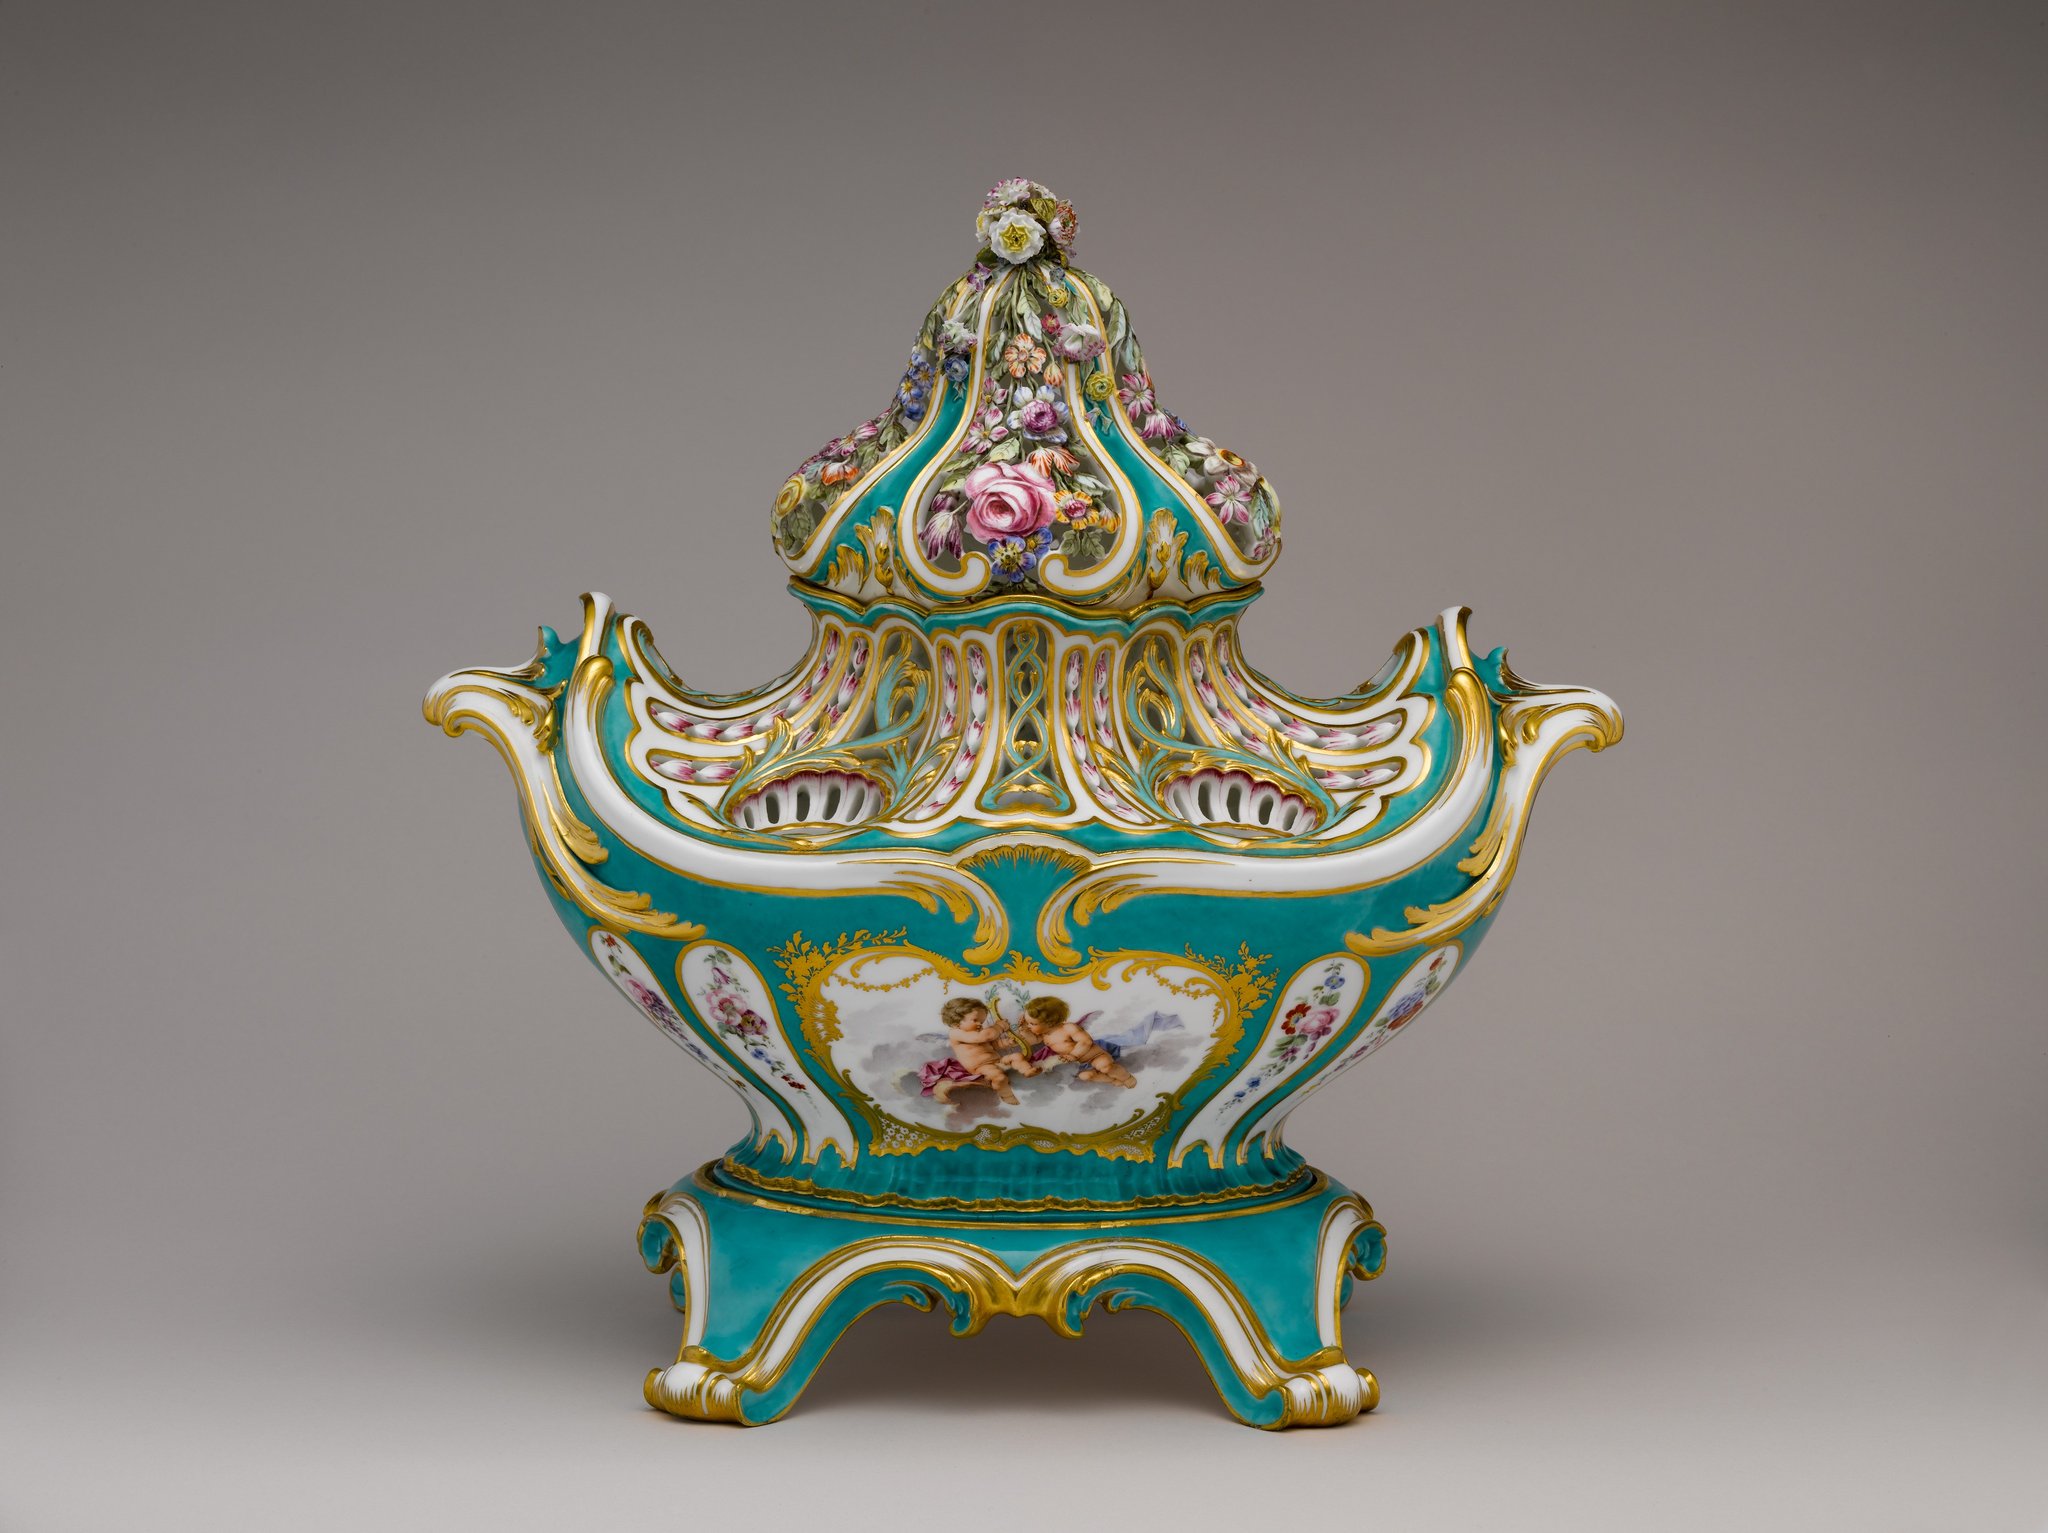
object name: potpourri vase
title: Potpourri vase (pot-pourri gondole)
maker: sèvres manufactory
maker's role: manufactory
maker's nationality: french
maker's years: 1740-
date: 1757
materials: enamel, gold, soft paste porcelain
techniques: polychrome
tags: putti,flowers